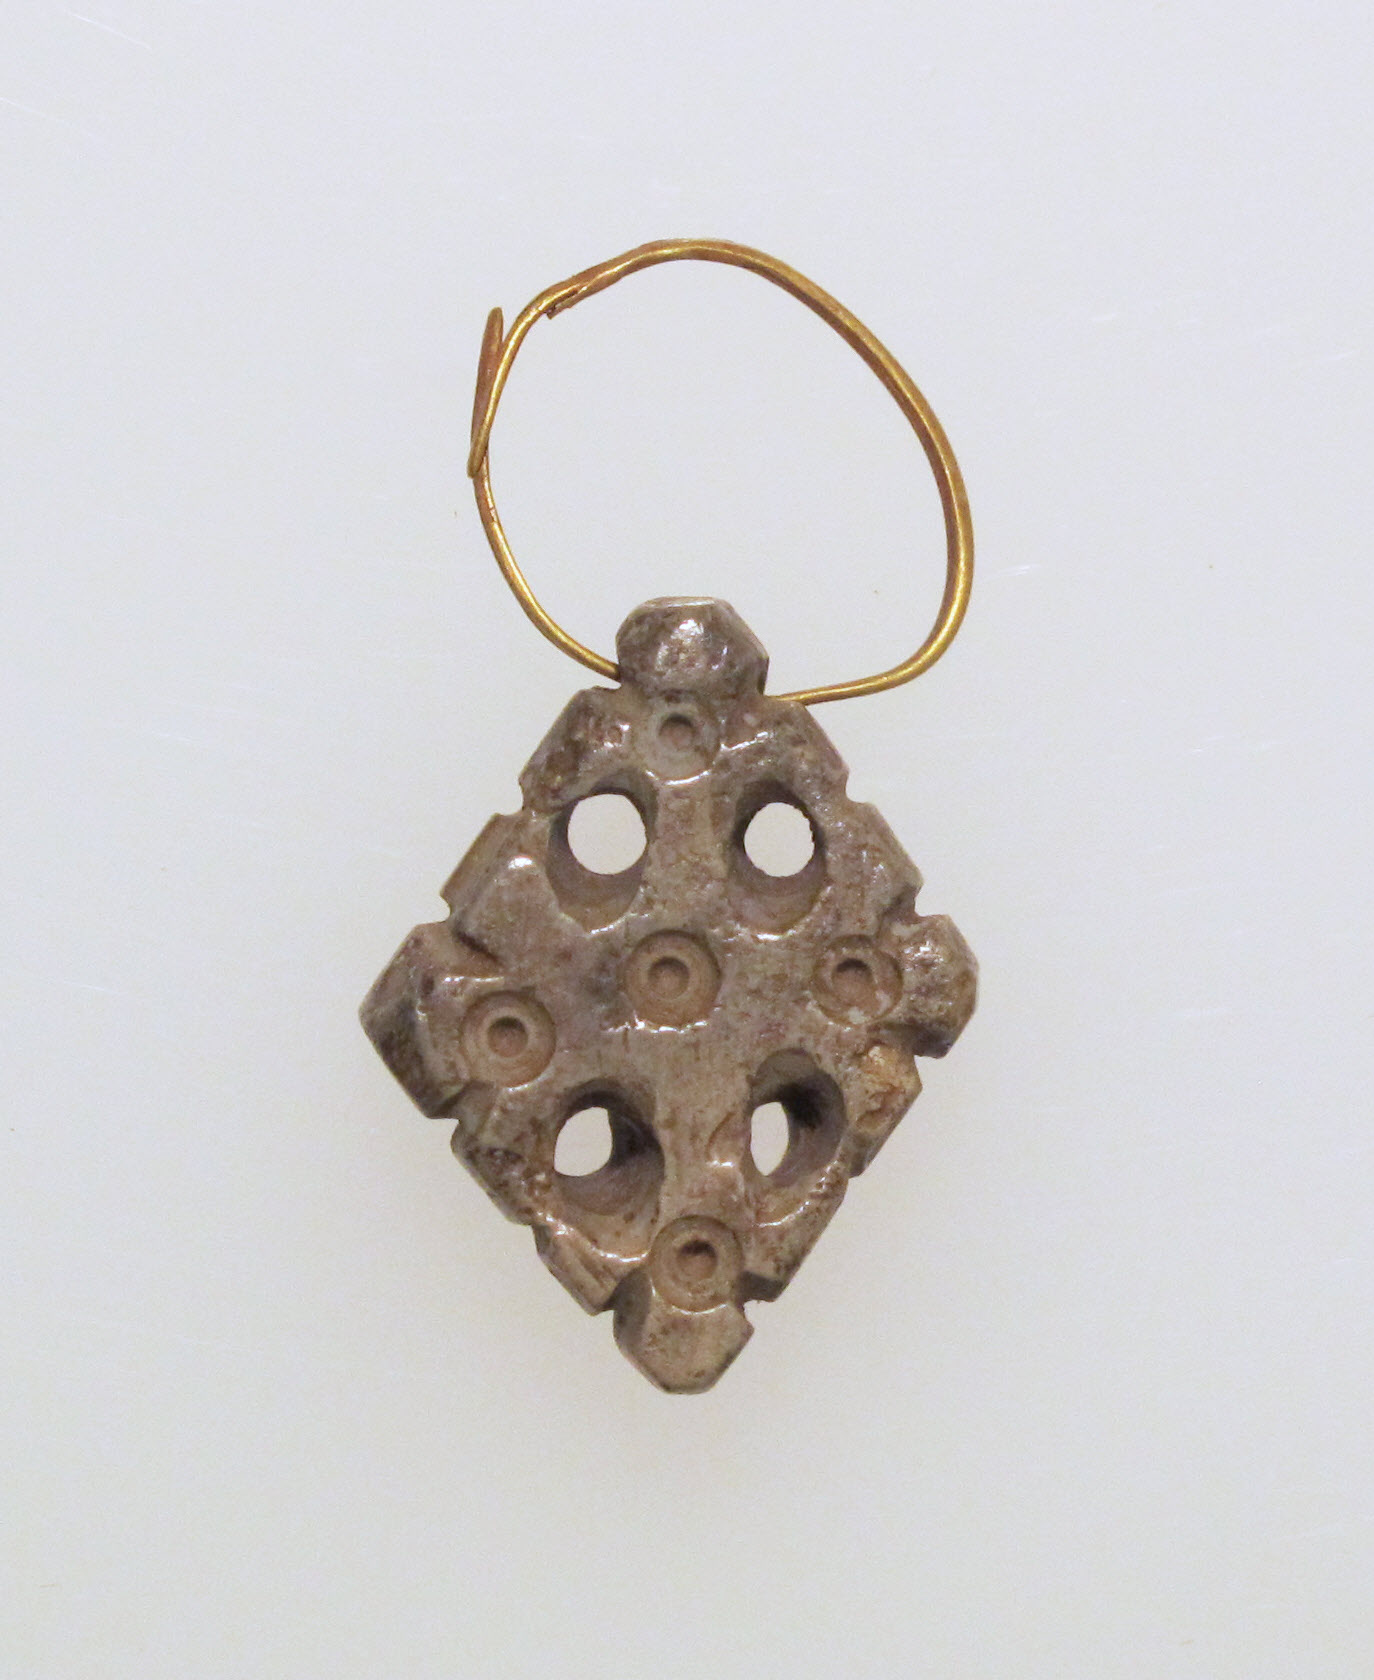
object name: earring with stone cross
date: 7000 BCE-330 CE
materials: gold, stone